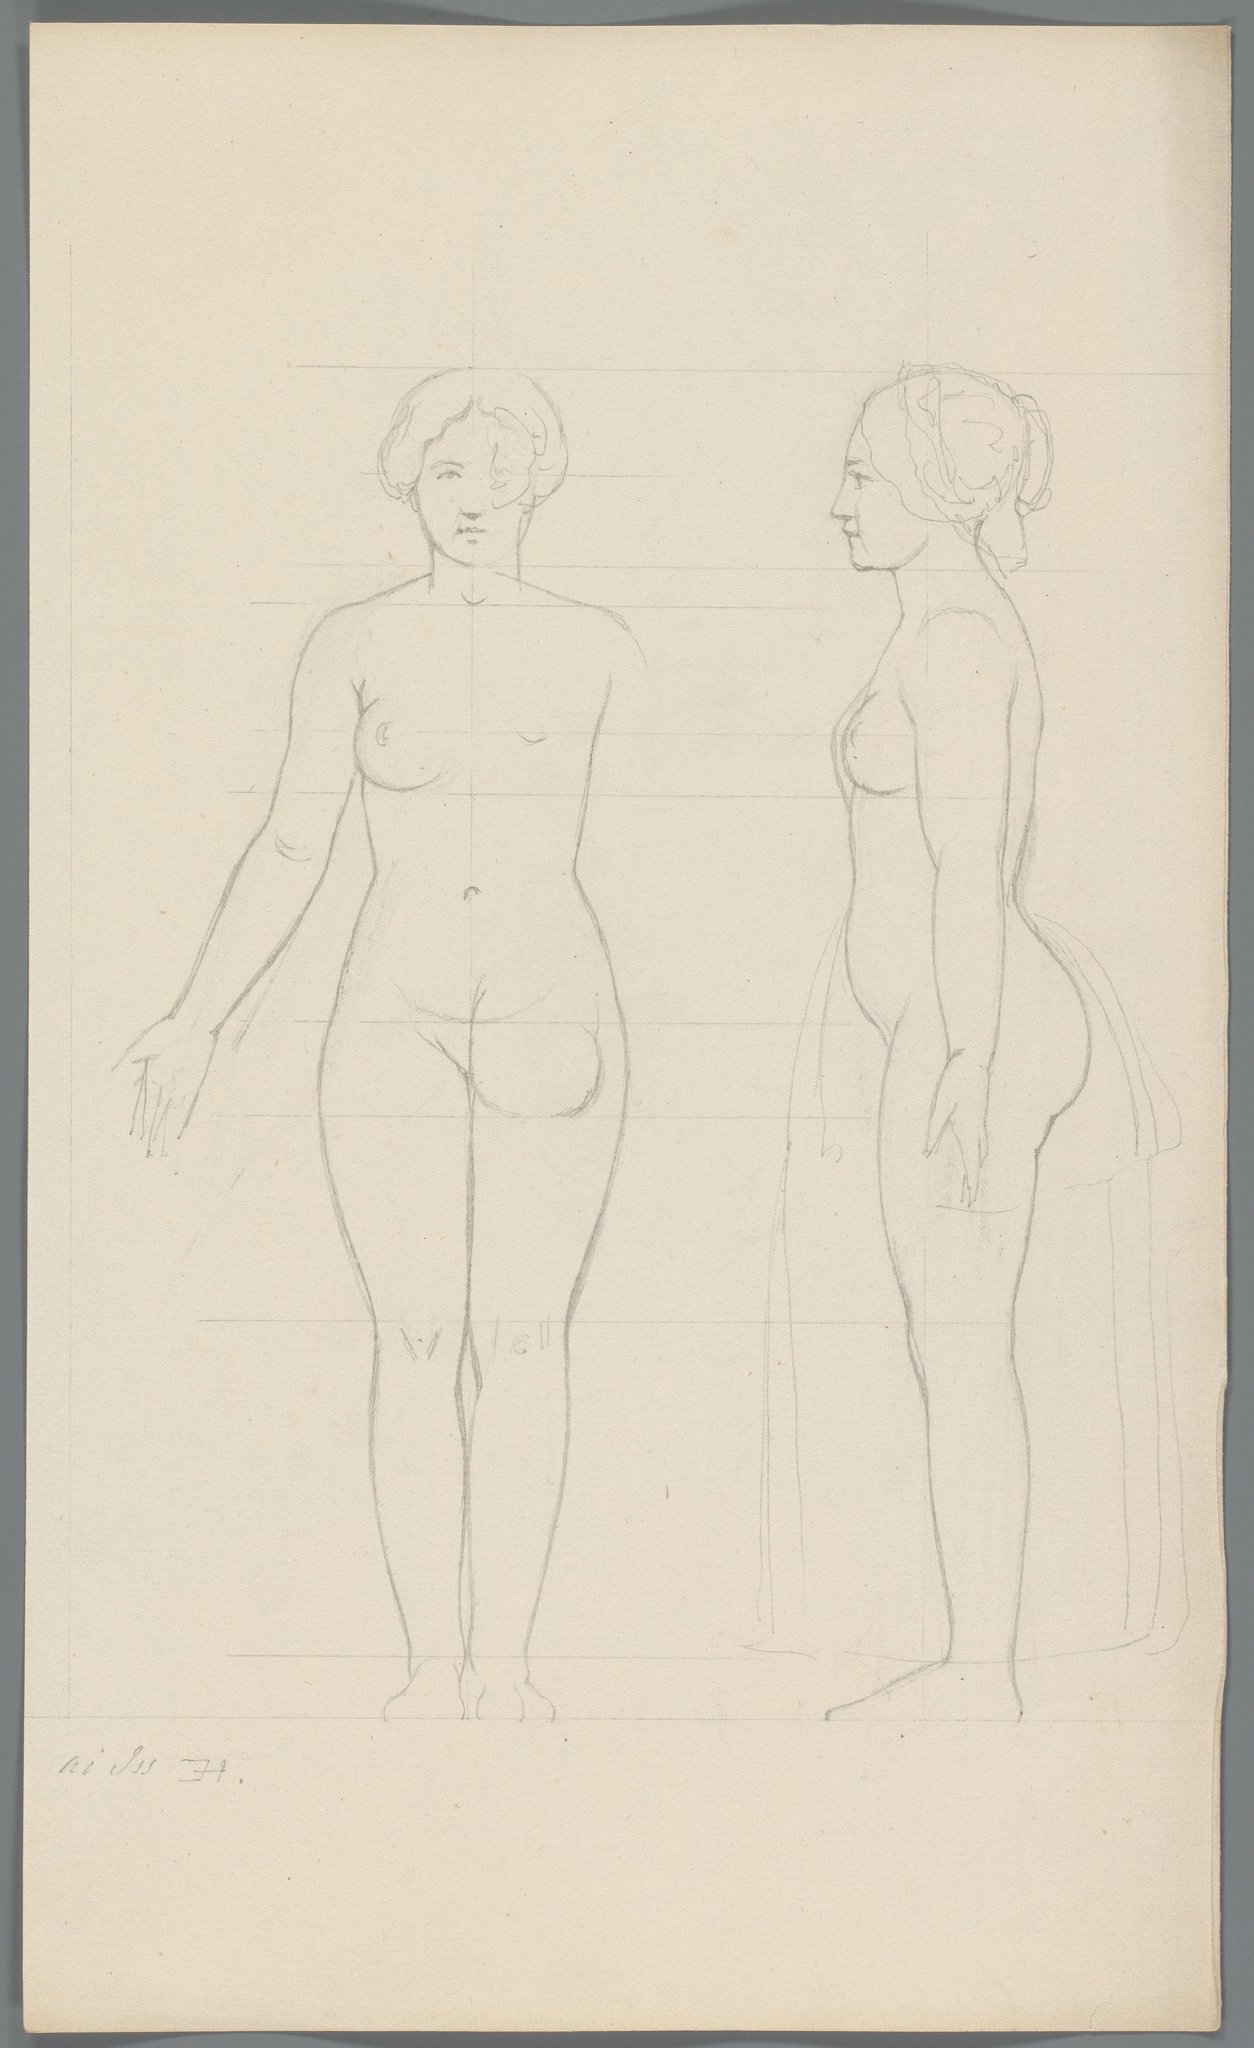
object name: drawing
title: Proportiestudie van een vrouw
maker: jacobus everhardus josephus van den berg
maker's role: draughtsman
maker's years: 1802-1861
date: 1858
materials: paper, pencil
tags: standing figure (canon, proportions) - aa - female human figure, anatomy (non-medical) - aa - female human figure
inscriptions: inscription: ‘ai Iss EH’